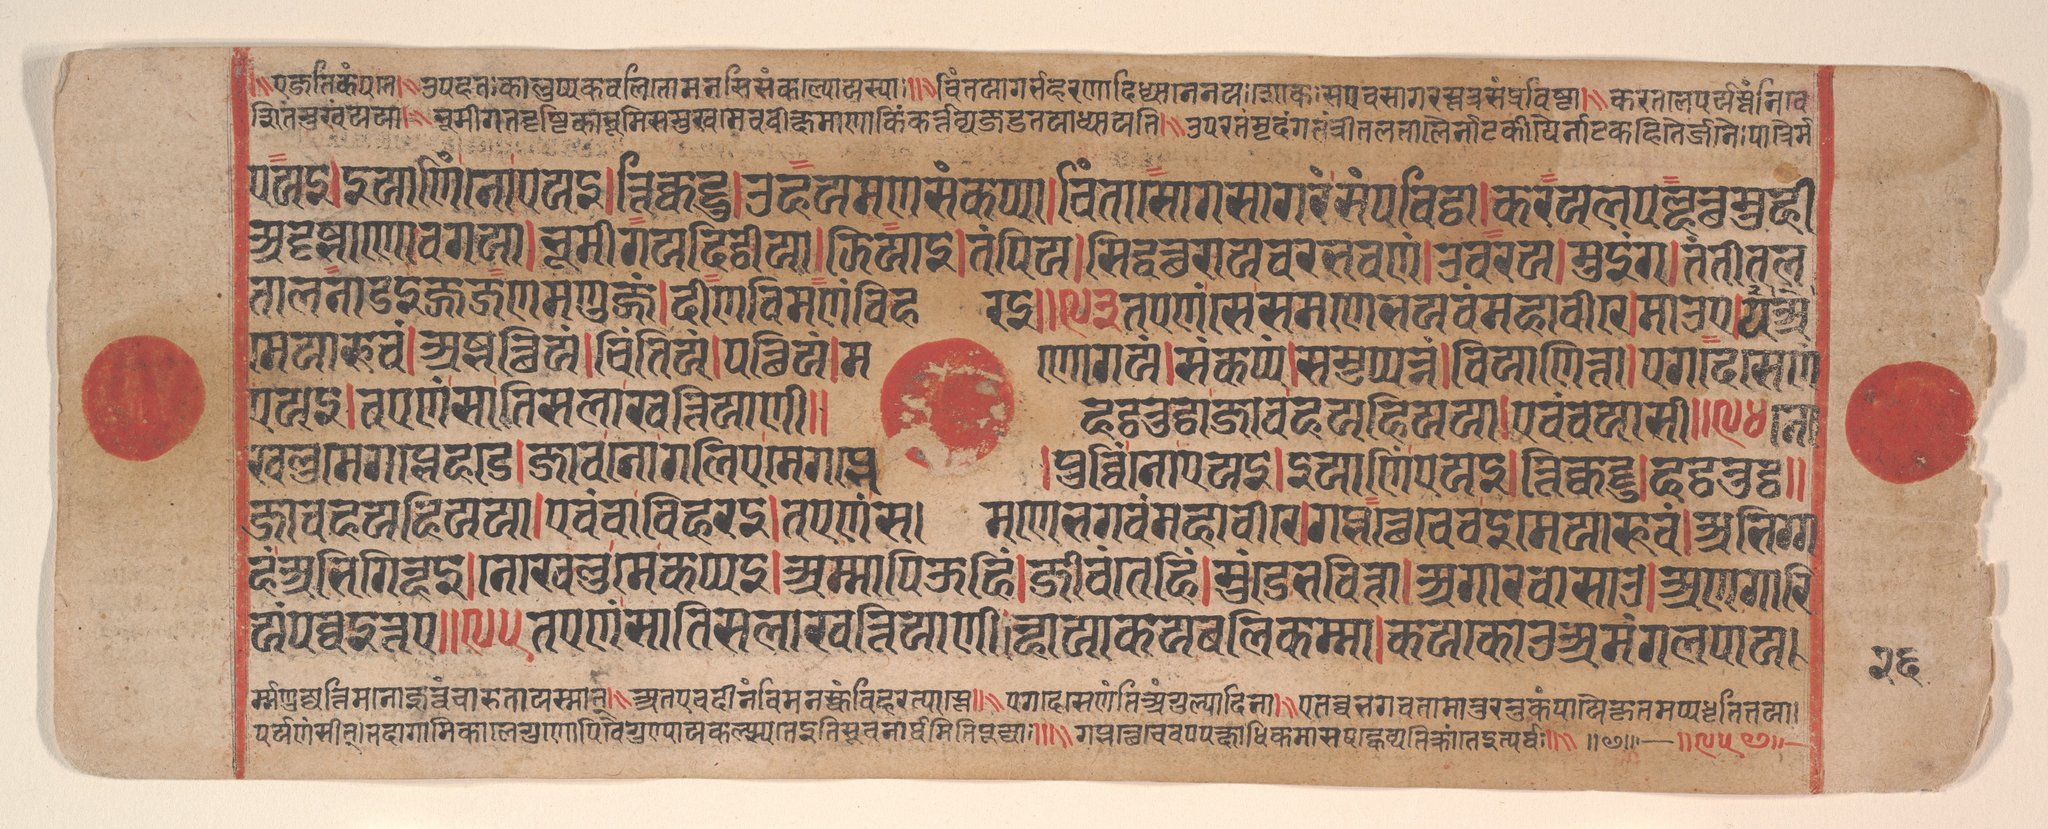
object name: folio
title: Leaf from a Kalpa Sutra (Jain Book of Rituals)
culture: indian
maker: bhadrabahu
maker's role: artist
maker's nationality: indian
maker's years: 356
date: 1401-1500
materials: gold, ink, paper, watercolor